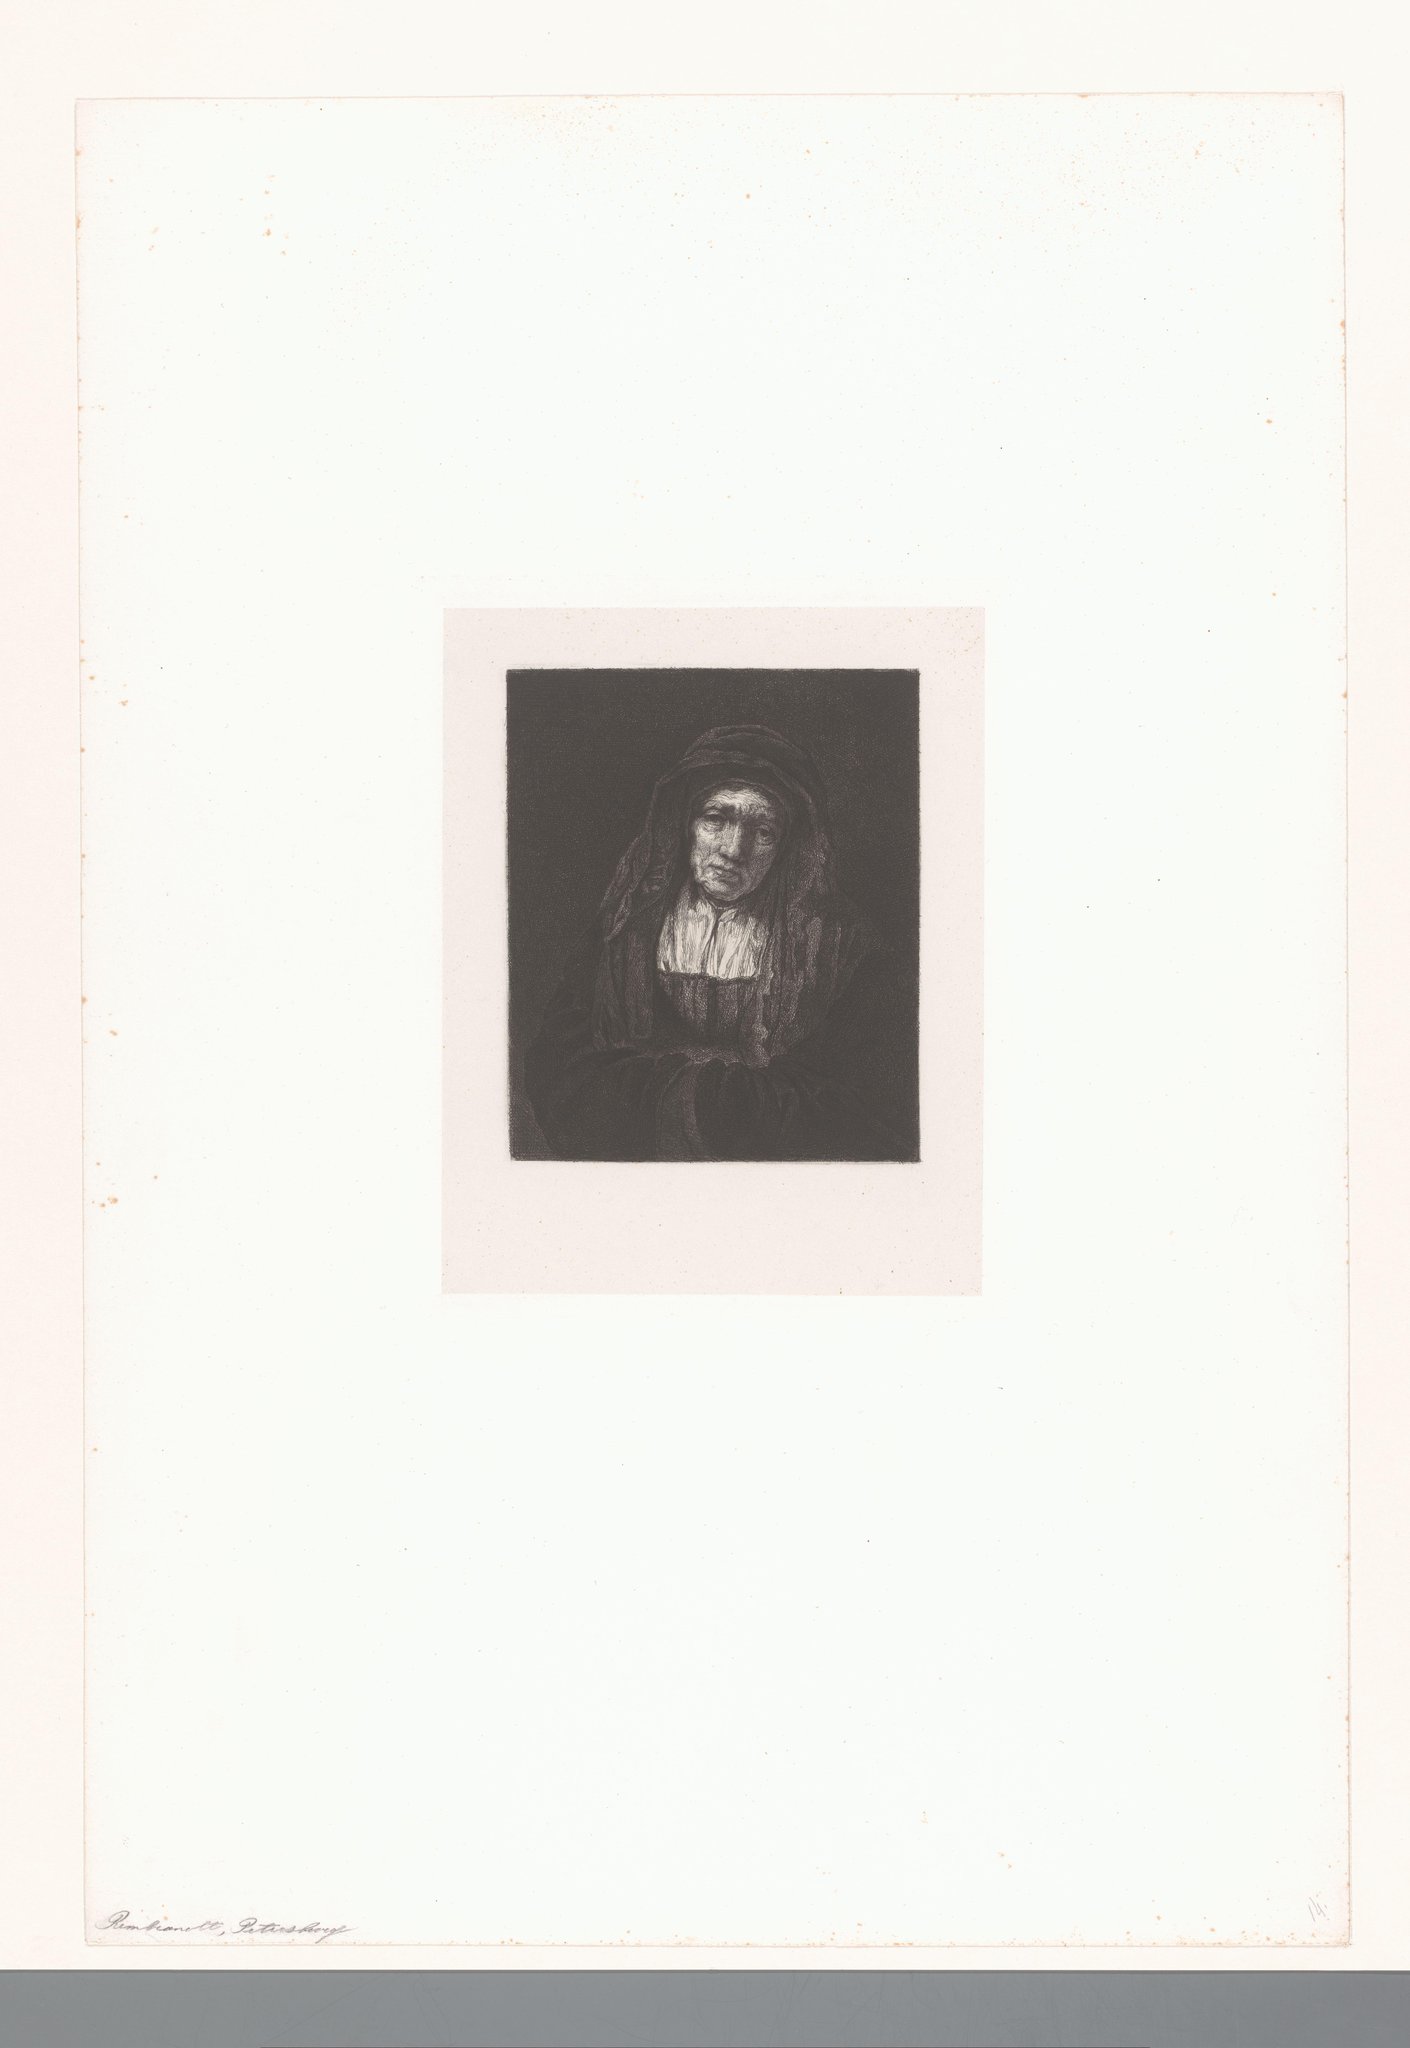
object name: print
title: Portret van een onbekende oude vrouw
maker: nikolay semyonovich mosolov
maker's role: print maker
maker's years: 1847-1914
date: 1857-1914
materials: paper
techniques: drypoint, etching, intaglio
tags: old woman